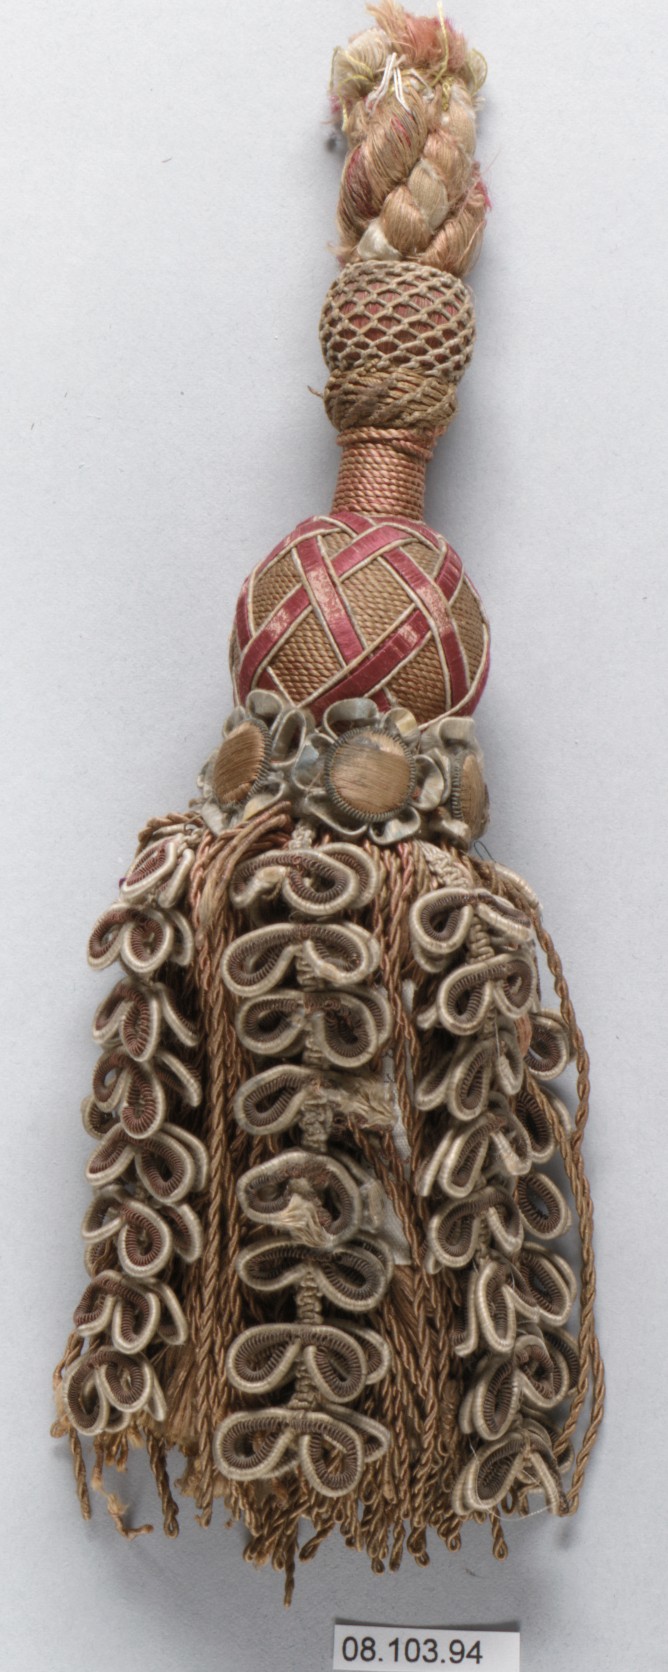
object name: tassel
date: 1801-1900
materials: silk